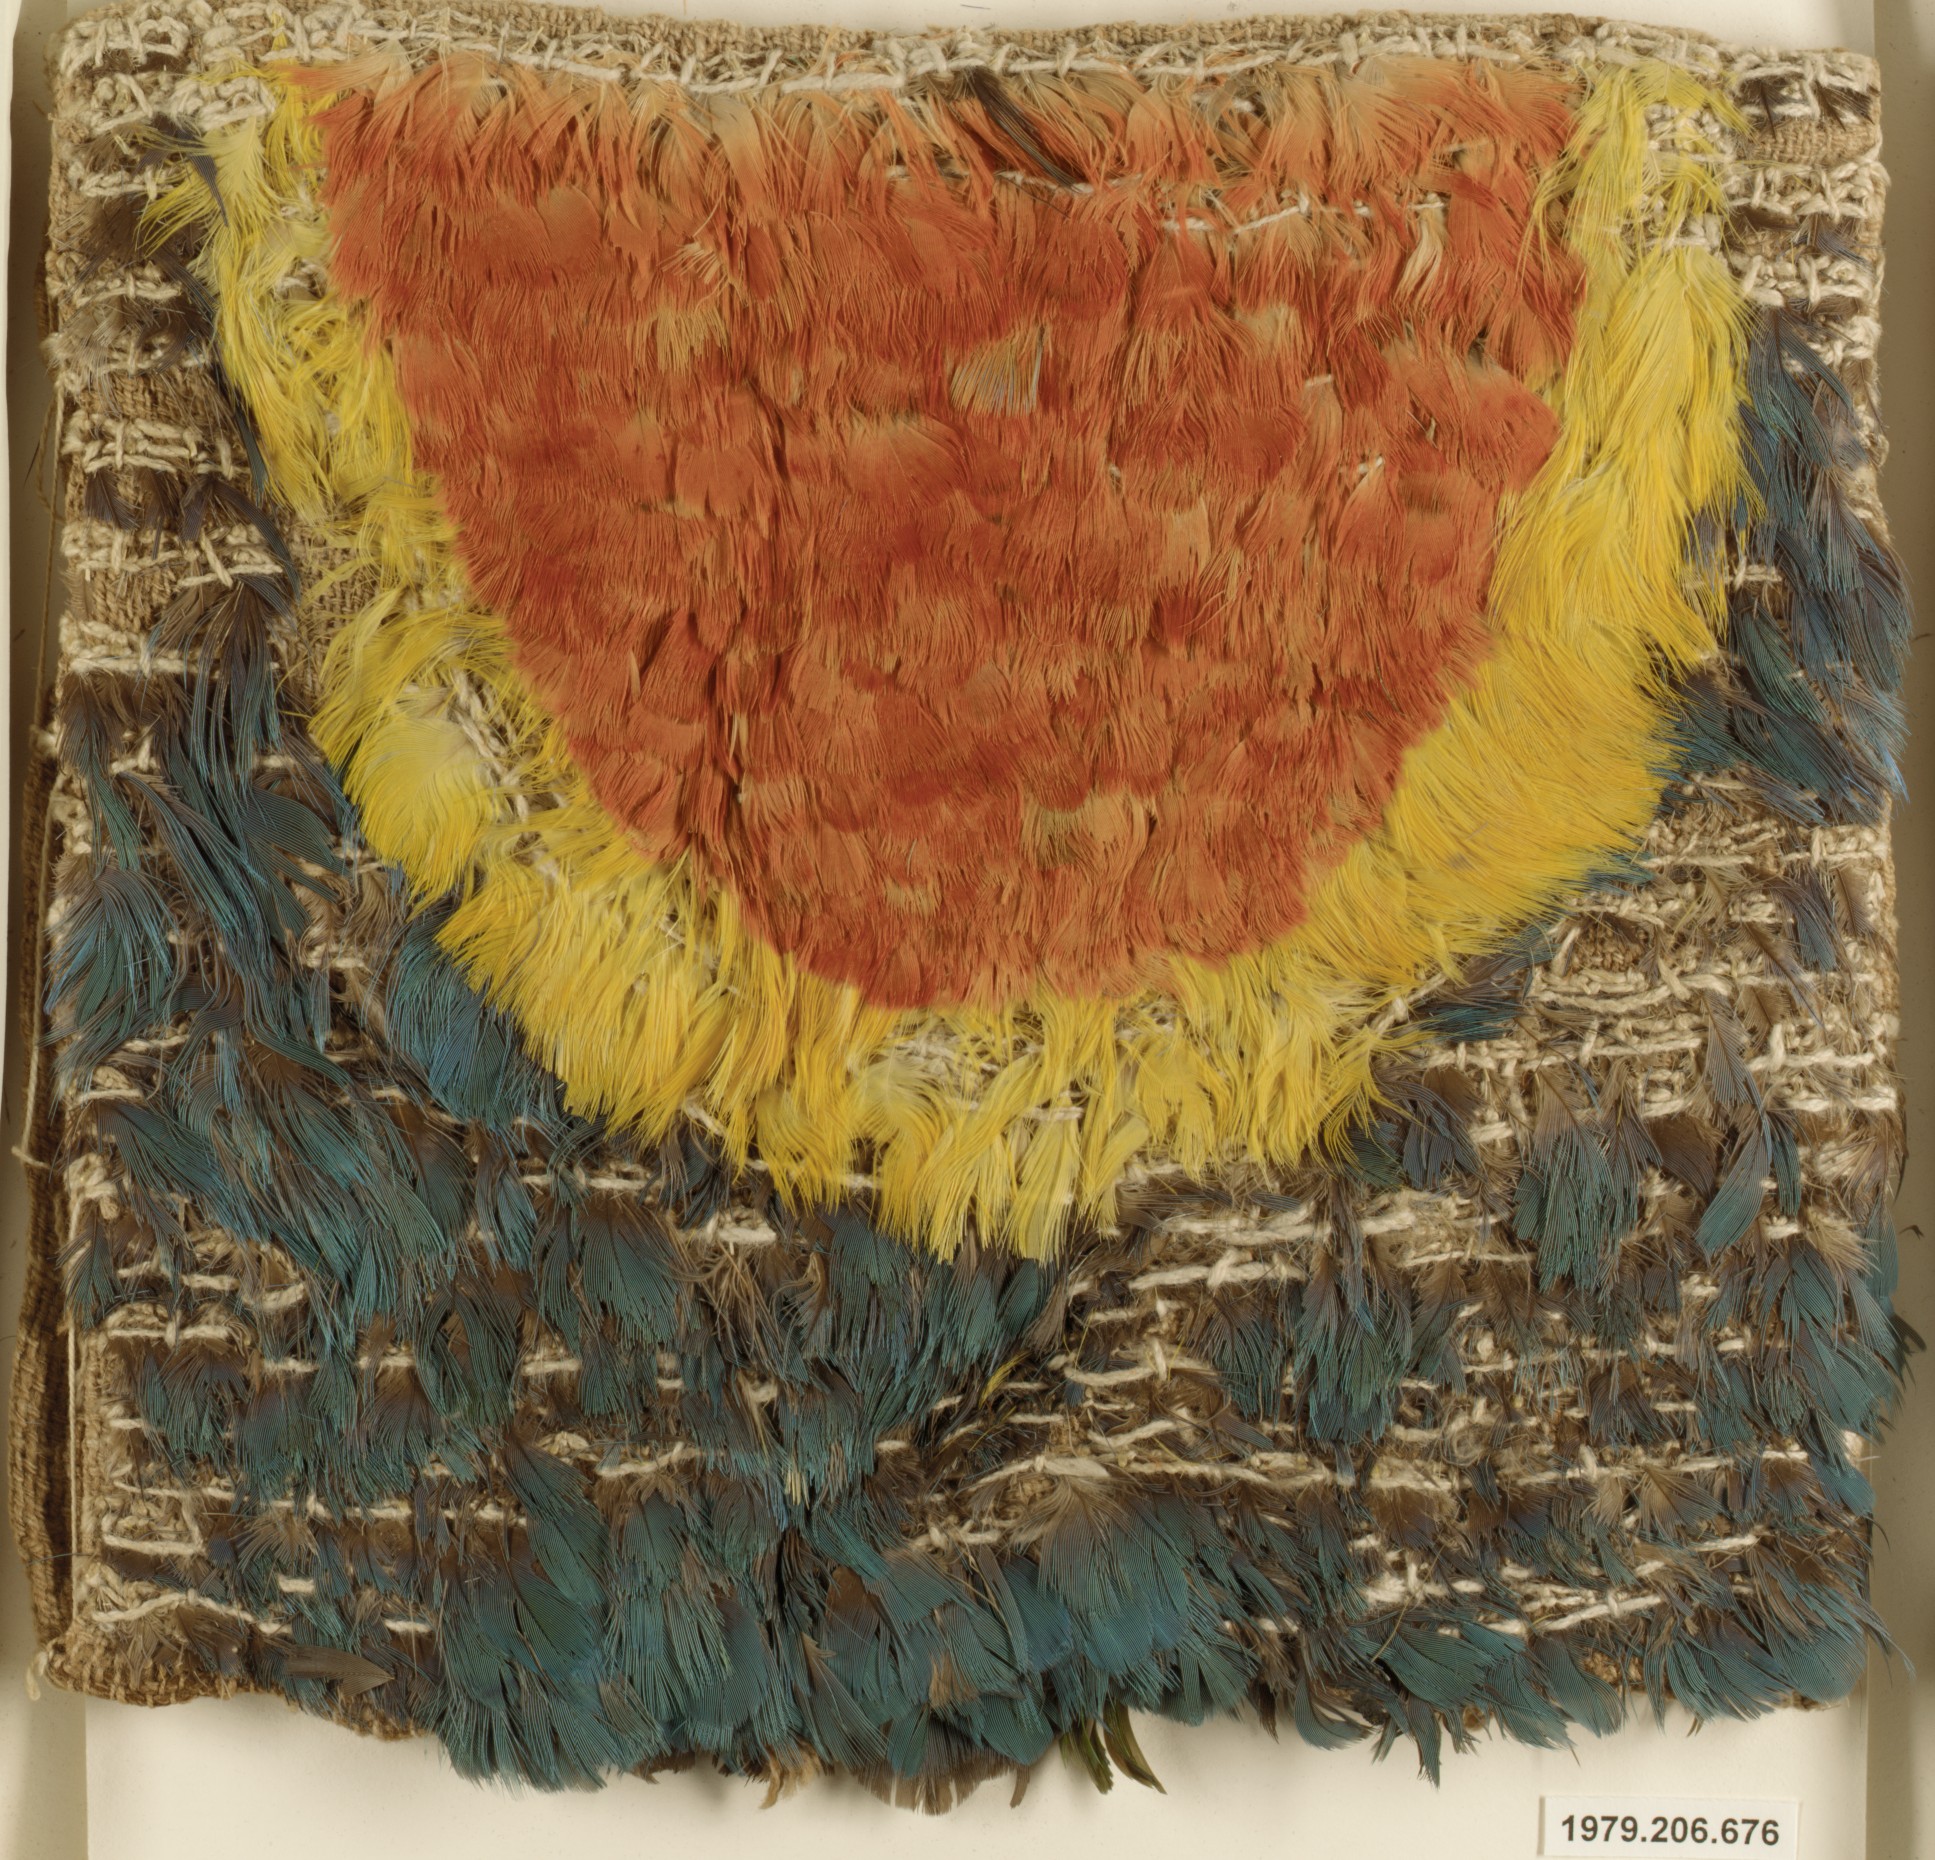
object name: miniature tunic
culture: ica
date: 1101-1300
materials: cotton, feather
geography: peru